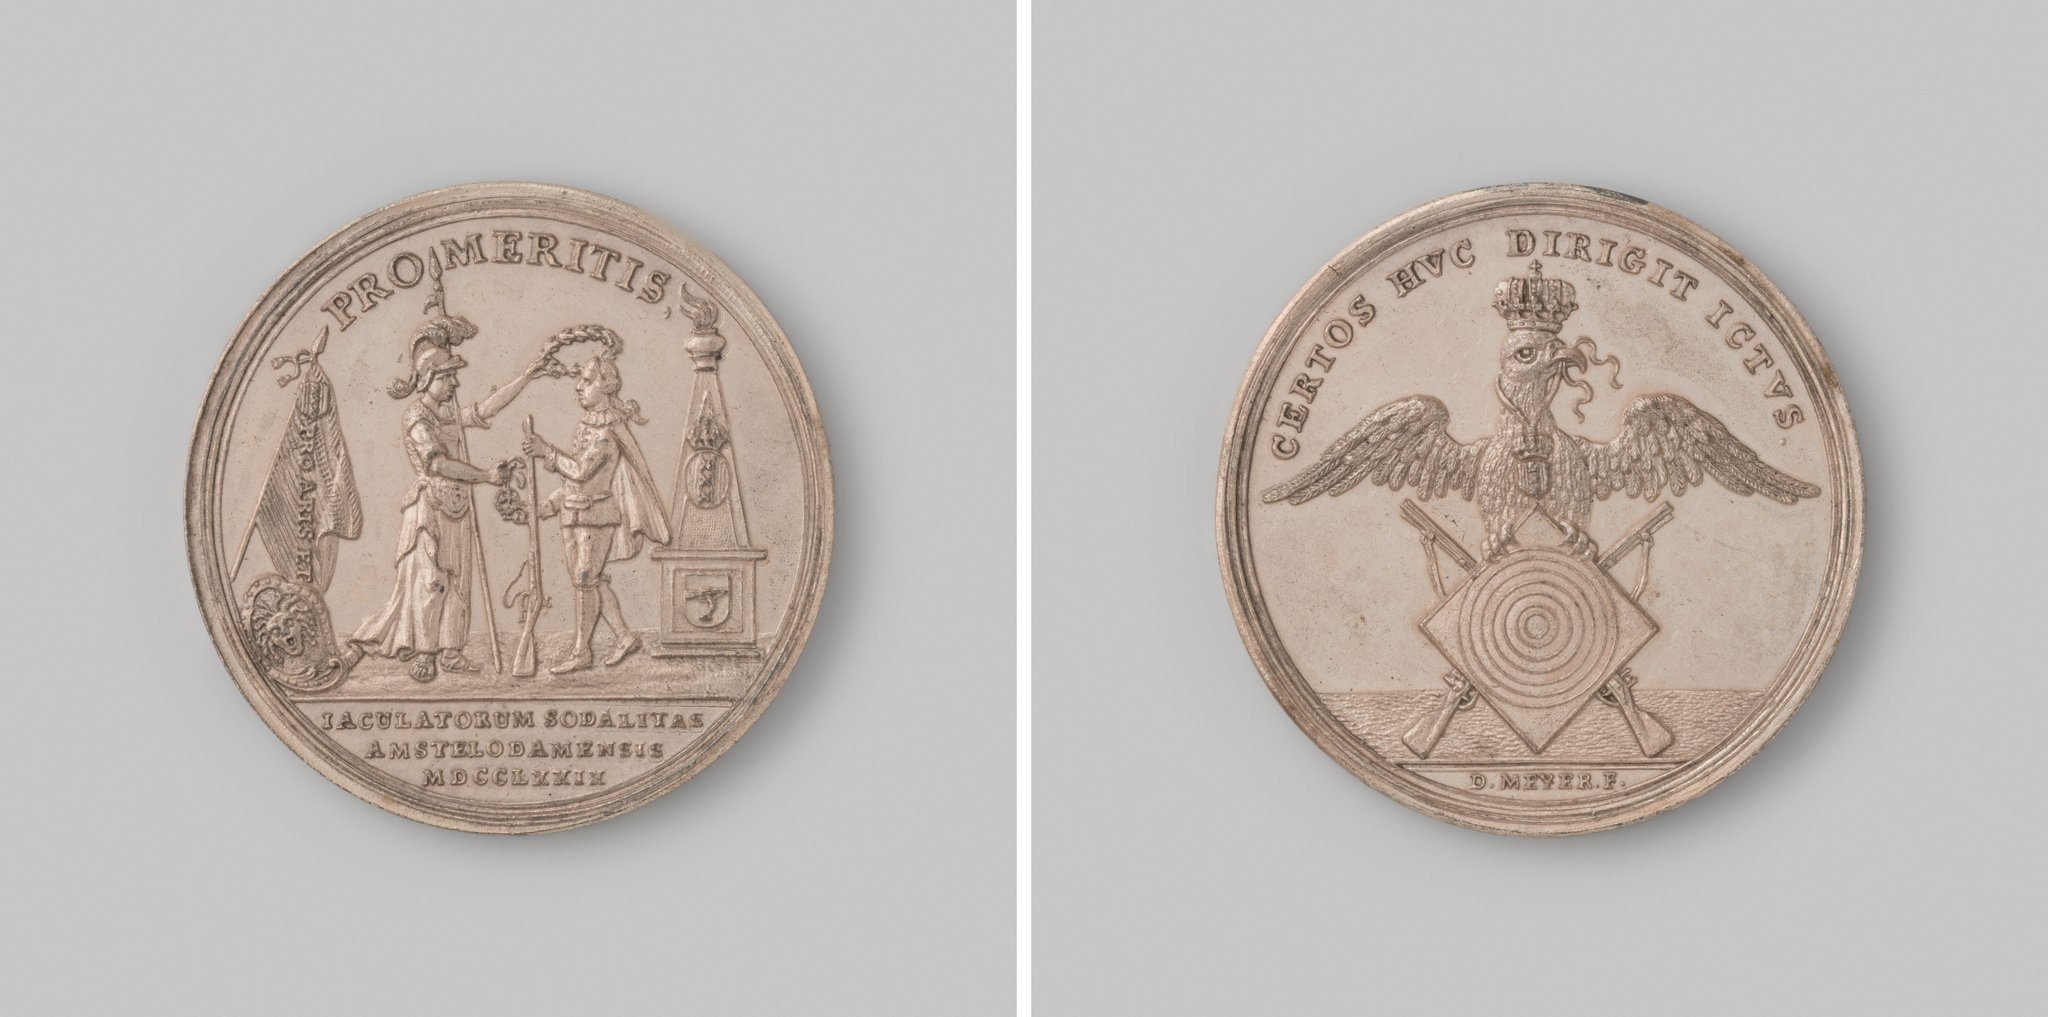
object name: history medal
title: Prijspenning van het Schuttersgezelschap te Amsterdam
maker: d. meyer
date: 1779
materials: silver